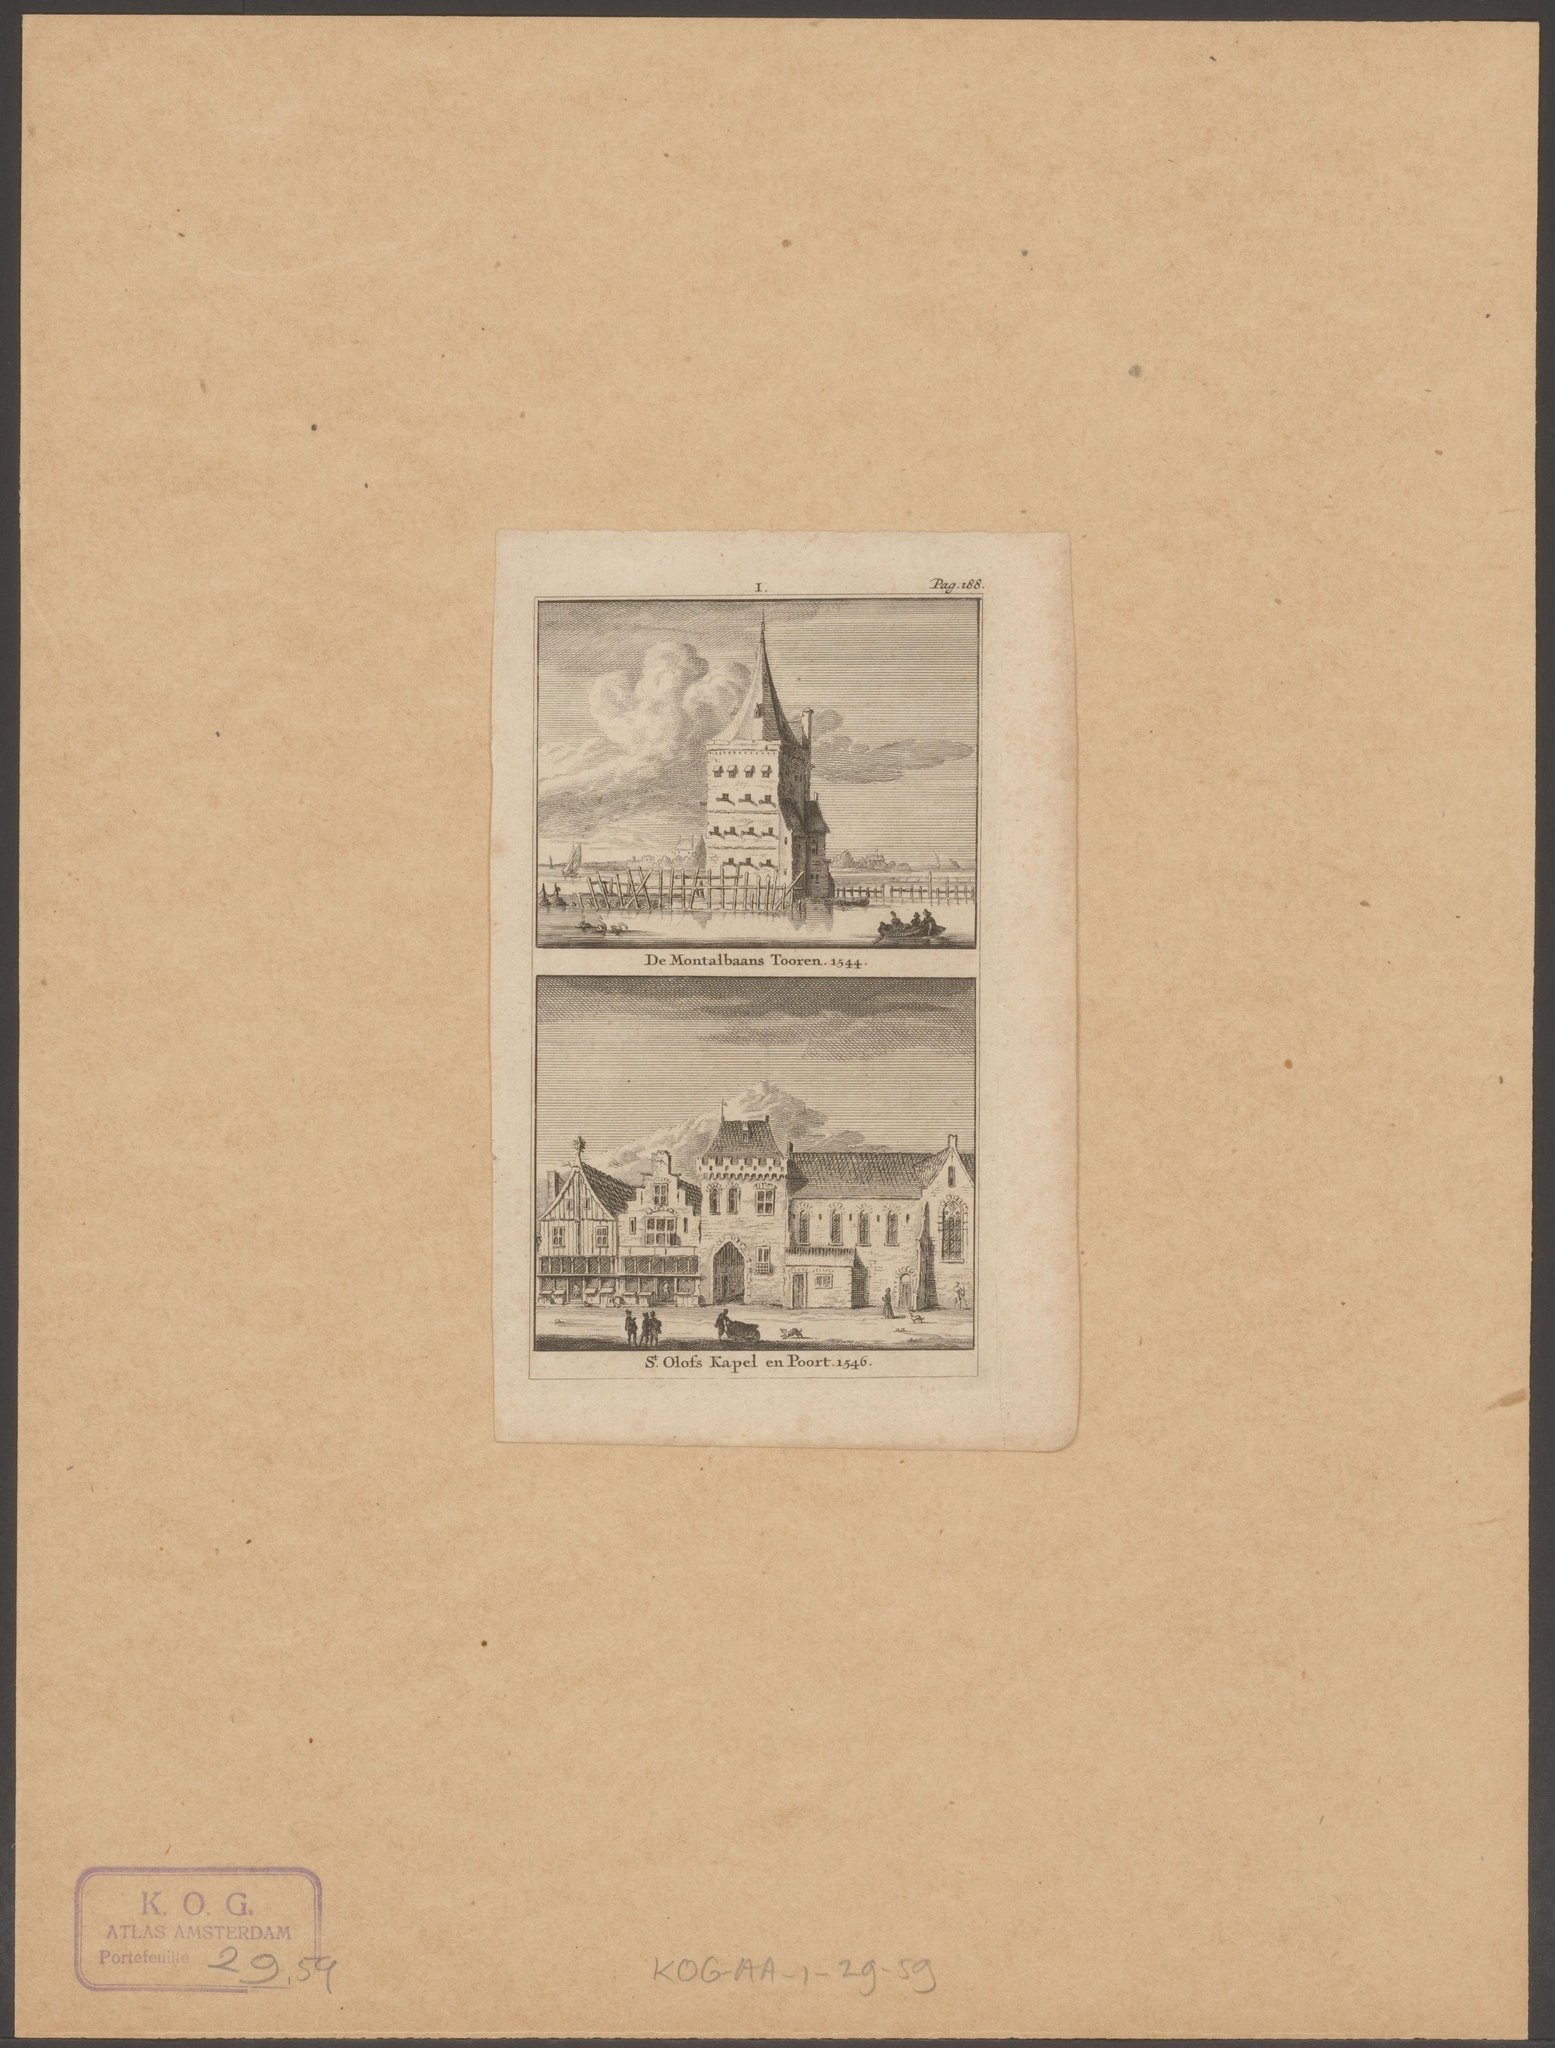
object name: print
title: De Montelbaans Tooren. 1544 / St Olofs Kapel en Poort. 1546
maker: jan goeree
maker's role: draughtsman, print maker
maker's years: 1670-1731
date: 1723-1738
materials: paper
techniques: engraving, etching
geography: amsterdam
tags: towers ~ fortified city, church (exterior) - qq - small church, chapel, city-gate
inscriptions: collector's mark: Lugt 1641b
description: Prent mogelijk uit: Willink, Daniël. Daniël Willinks Amsterdamsche Buitensingel Nevens de omleggende dorpen, opgeheldert door aanteekeningen (…). Amsterdam: Andries van Damme, 1723. Of uit: Willink, Daniël. Daniël Willinks Amsterdamsche Buitensingel, Nevens de omleggende dorpen, opgeheldert door aanteekeningen (…). Amsterdam: Arend van Huyssteen, 1738.